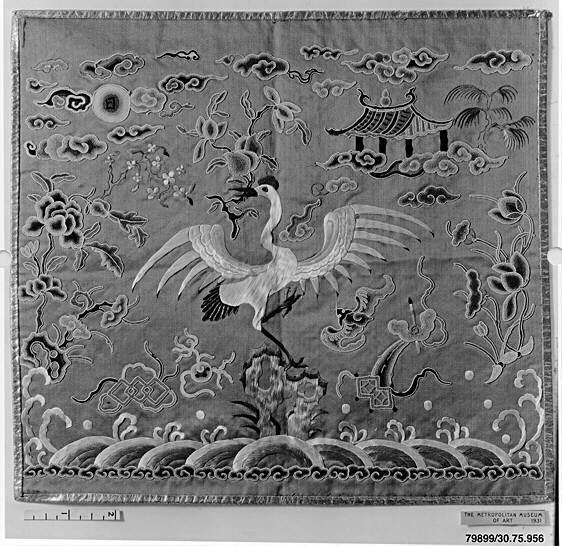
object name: rank badge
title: Rank Badge with Manchurian Crane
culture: chinese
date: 1701-1733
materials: metal thread, silk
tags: bats,cranes